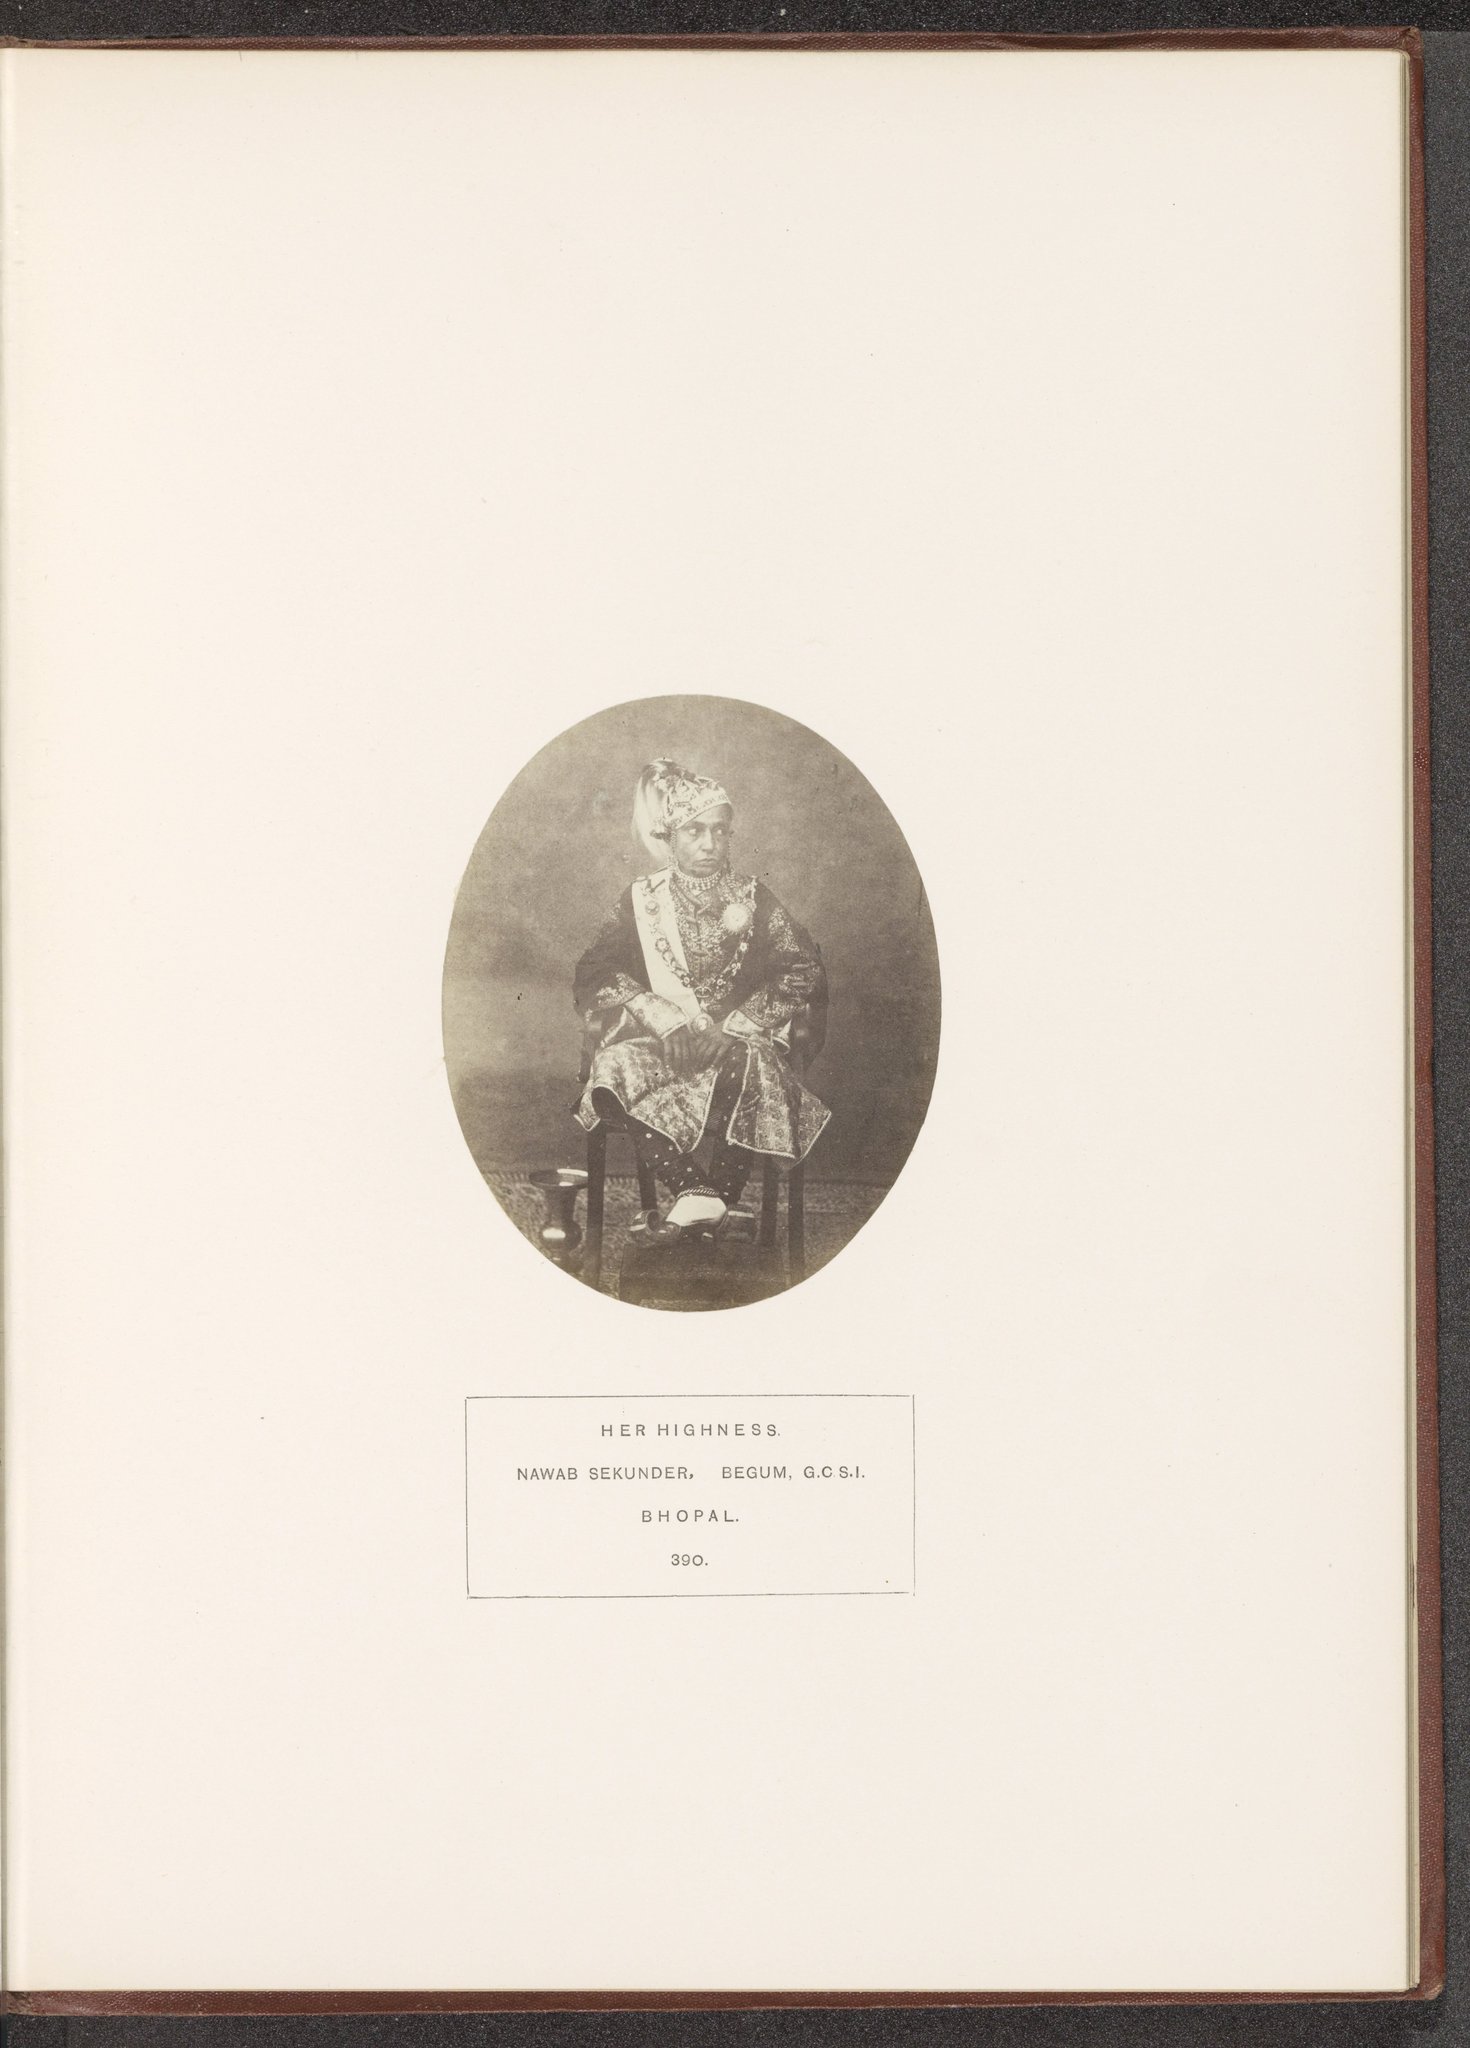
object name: page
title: Portrait of Sekunder Begum, a queen of Bhopal, Madhya Pradesh, India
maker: james john waterhouse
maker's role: fotograaf, luitenant, officier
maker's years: 1842-1928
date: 1811-1862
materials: photographic support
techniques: albumen print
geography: bhopal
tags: ruler, sovereign - bb - female ruler, human races; peoples; nationalities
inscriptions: inscription: ‘HER HIGHNESS./ NAWAB SEKUNDER, BEGUM G.C.S.I./ BHOPAL.’, number: ‘390.’